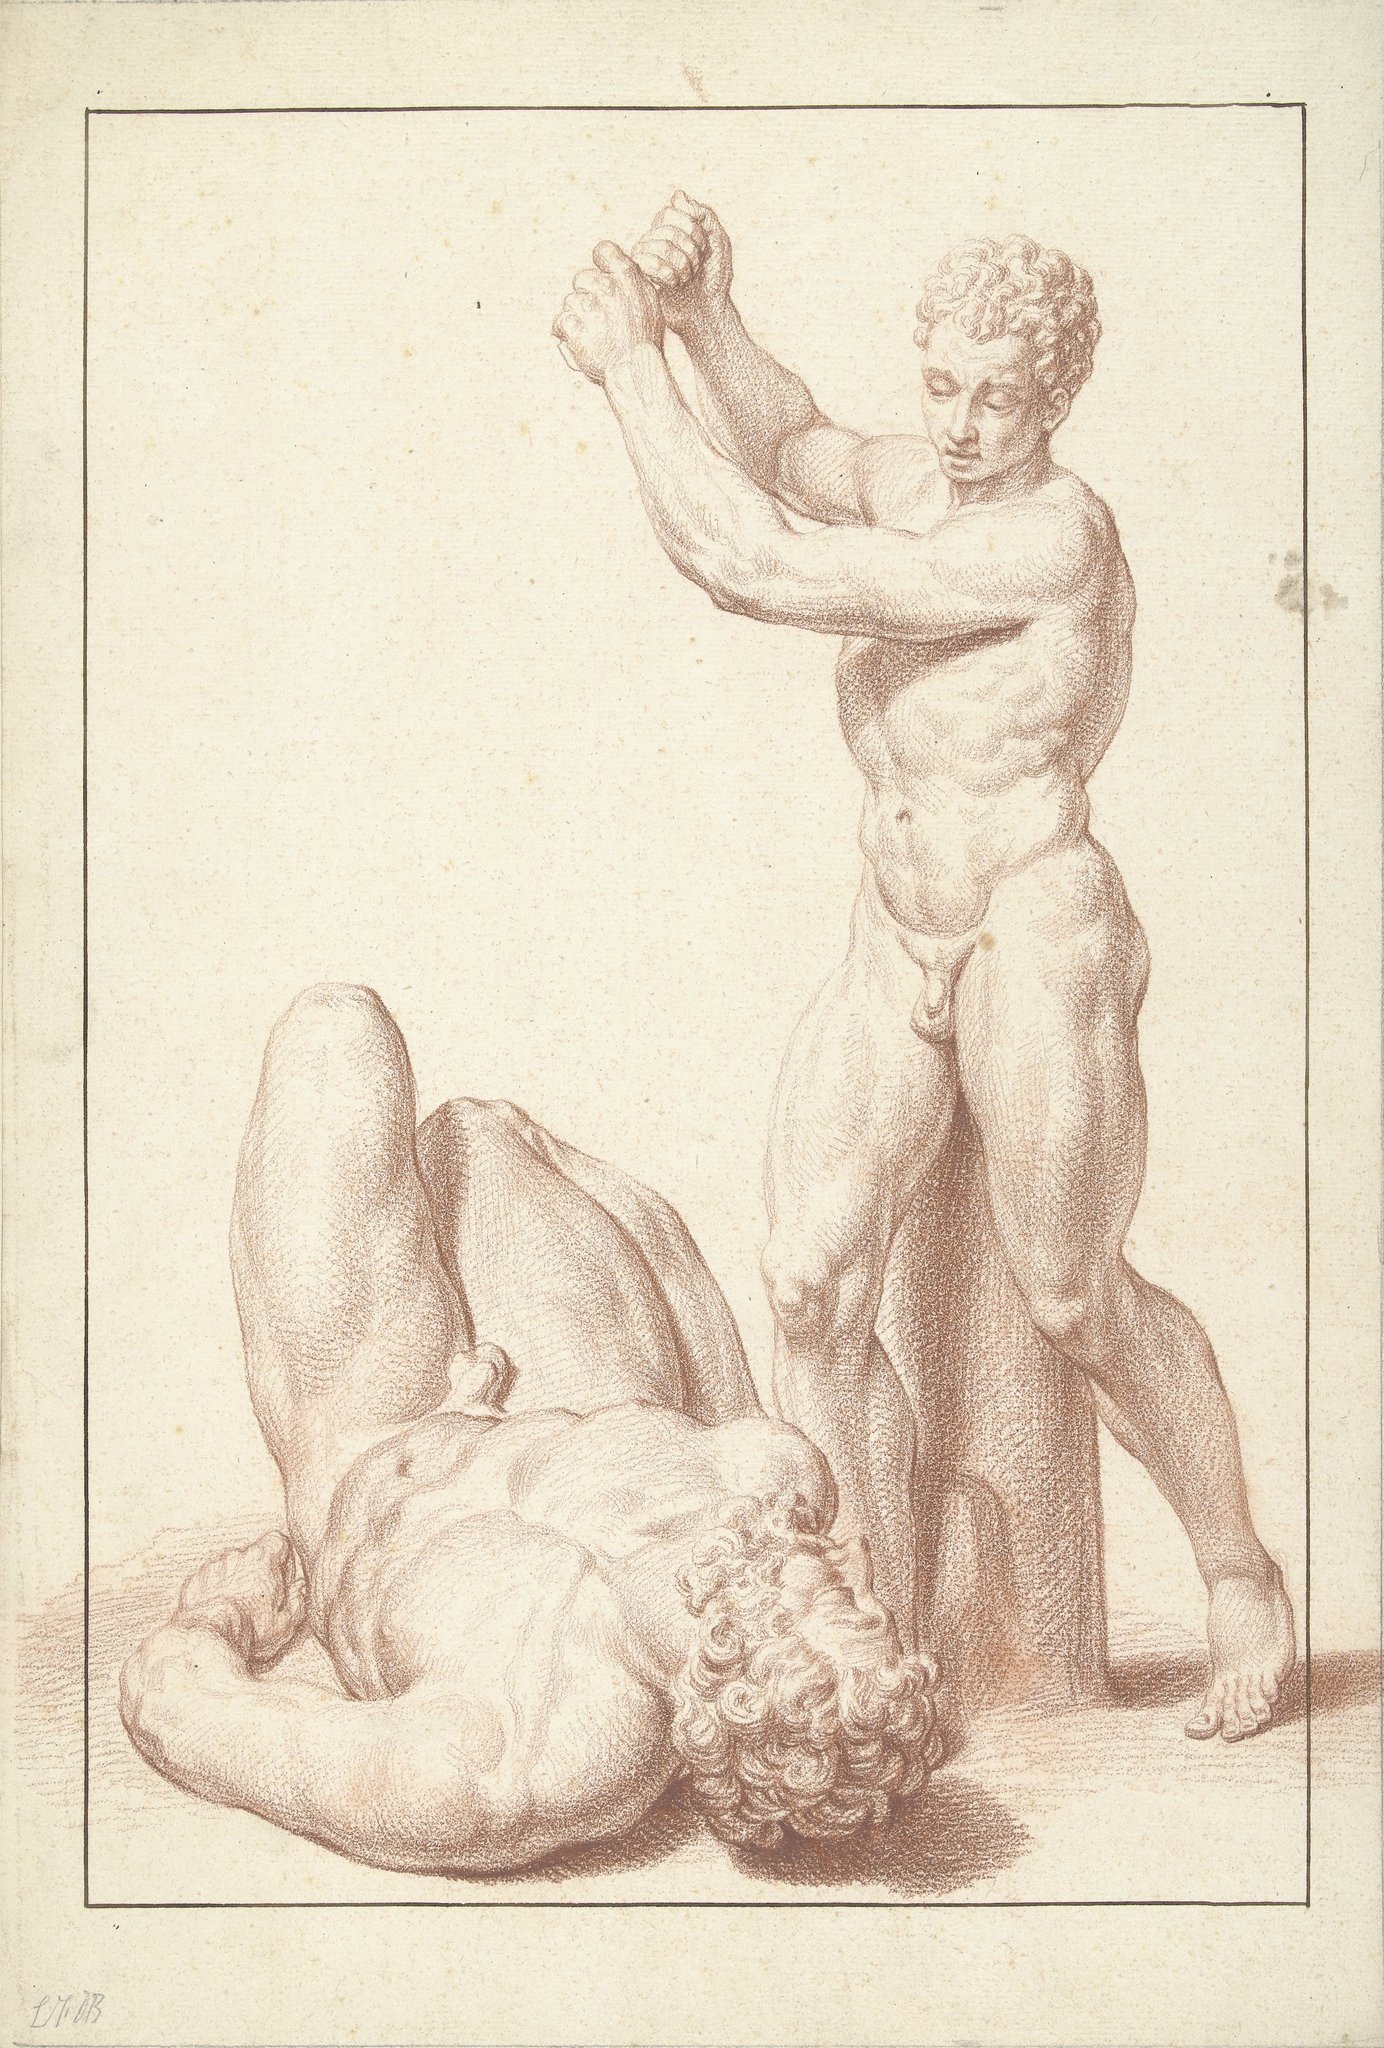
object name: drawing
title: Beeld van een jongen met opgeheven armen bij een liggende man met baard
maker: louis fabritius dubourg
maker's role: draughtsman, print maker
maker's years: 1693-1775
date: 1703-1775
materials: chalk, paper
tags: the (nude) human figure; 'corpo humano' (ripa) (+ two persons)